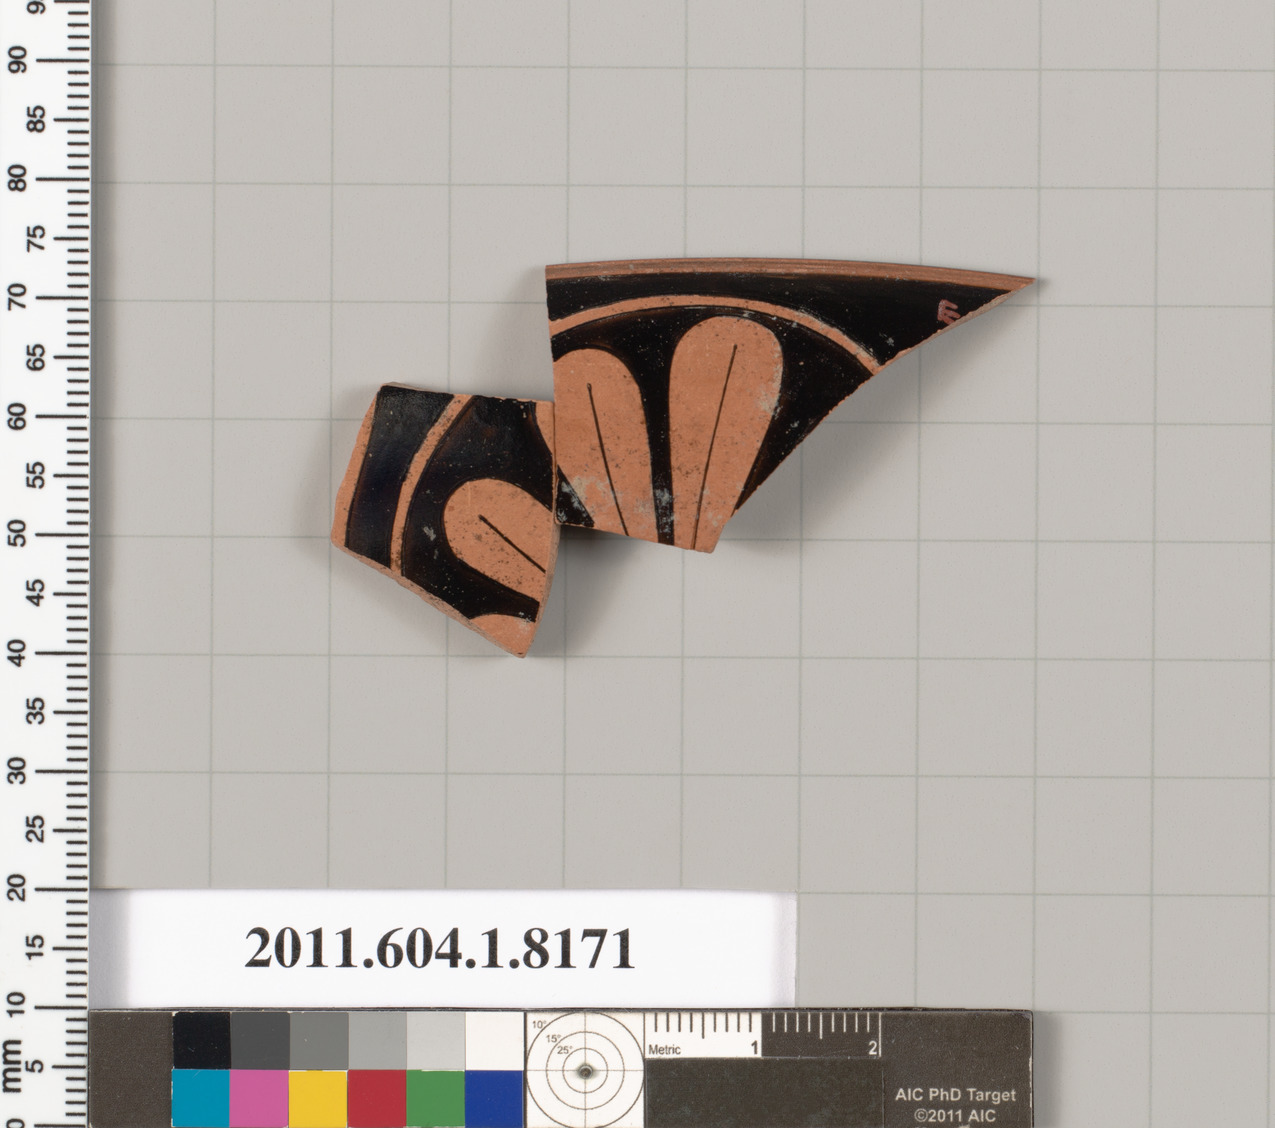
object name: kylix fragment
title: Terracotta fragment of a kylix (drinking cup)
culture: greek, attic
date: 520-510 BCE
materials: terracotta